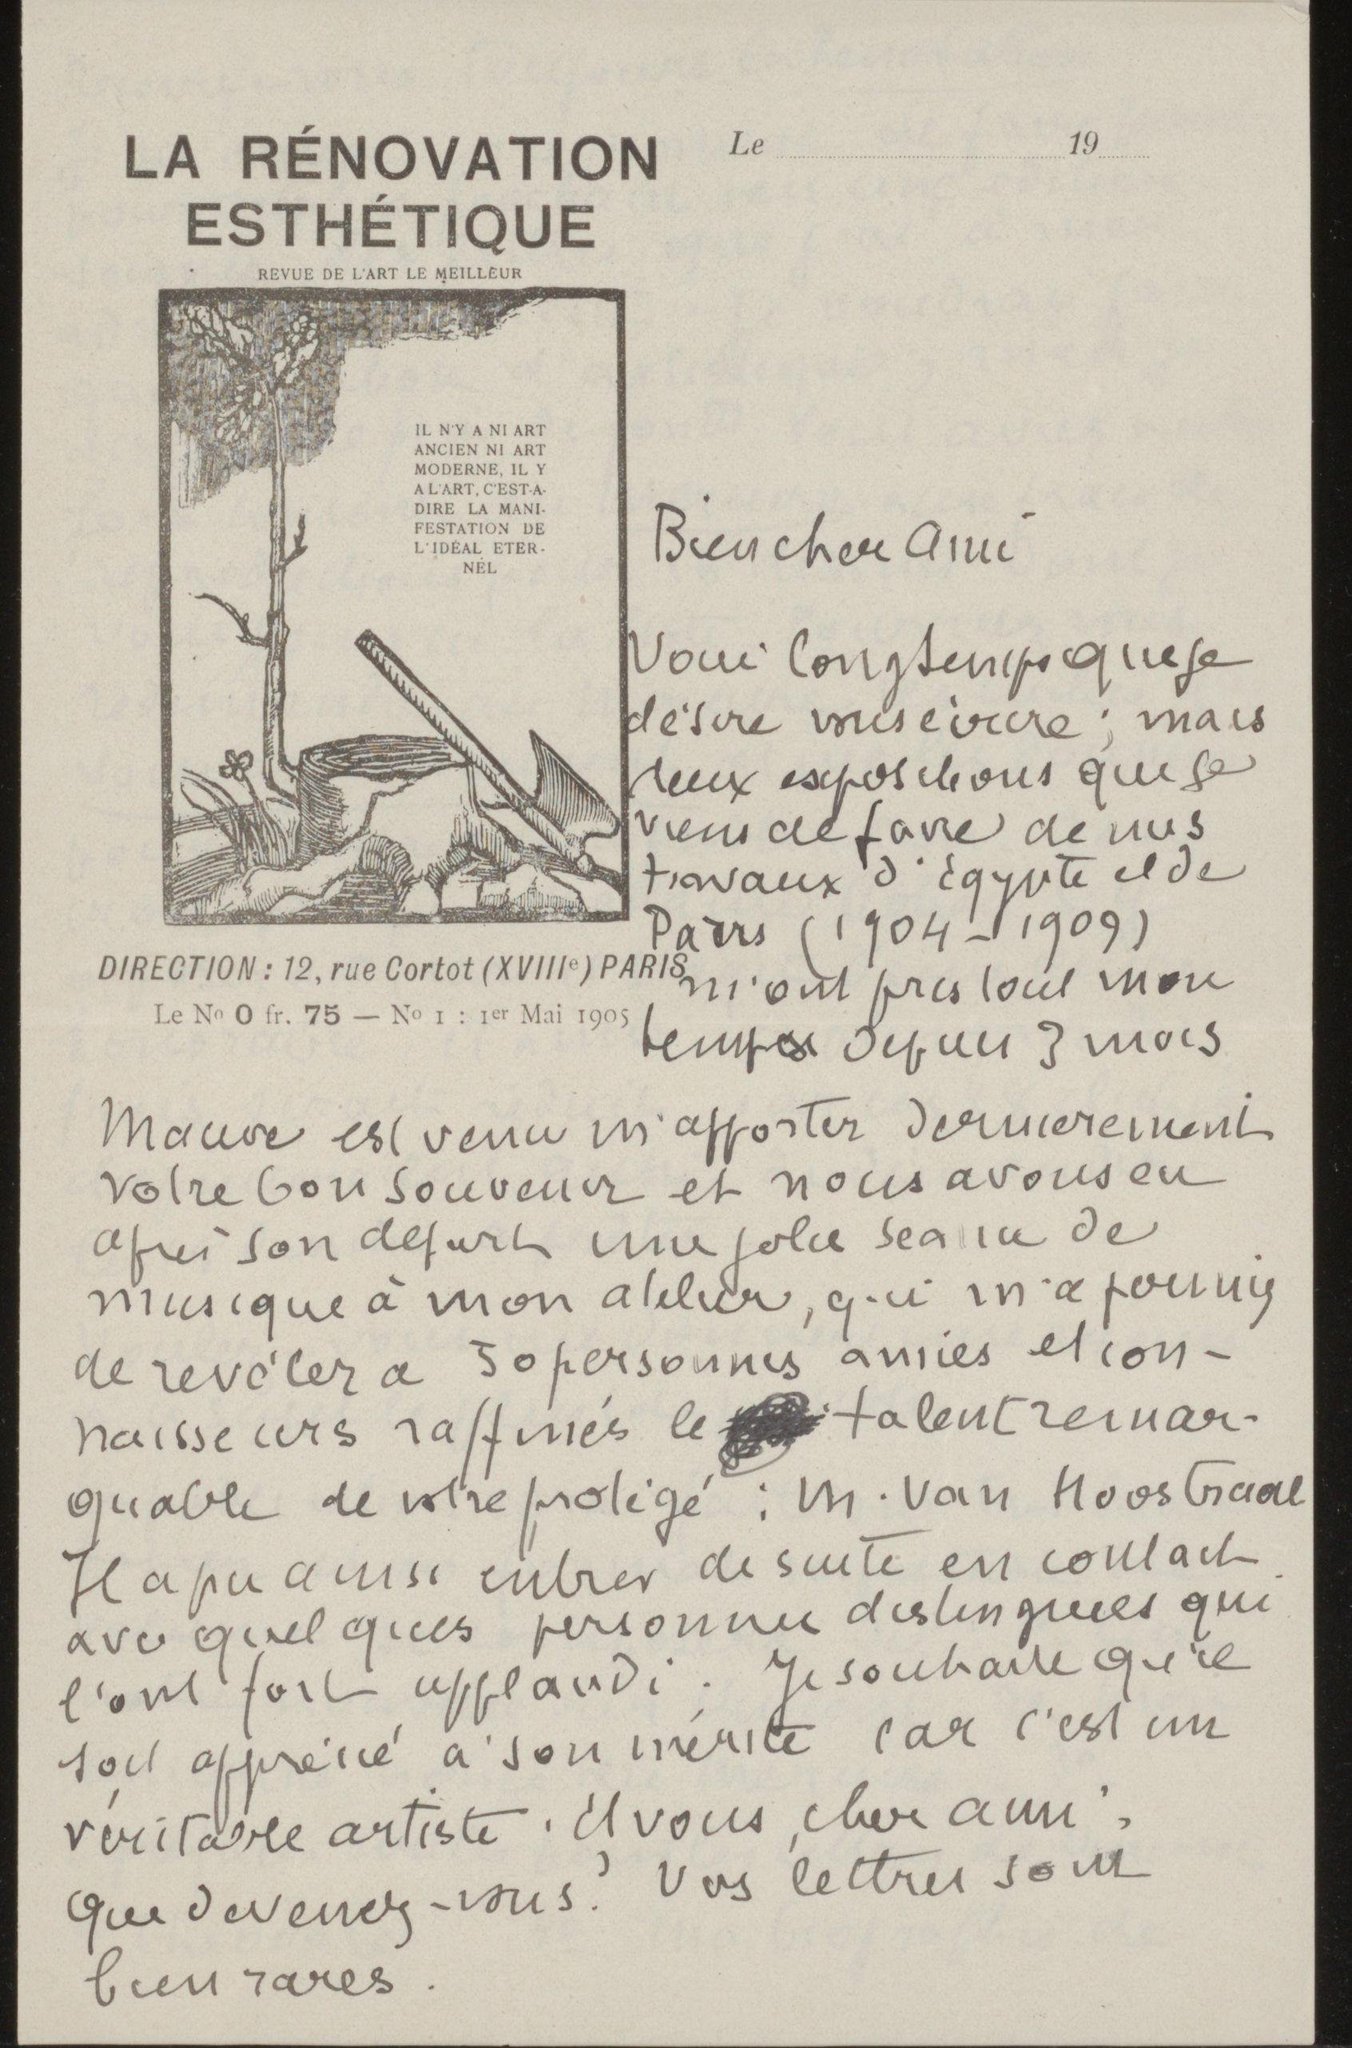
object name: letter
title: Brief aan Andries Bonger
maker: émile bernard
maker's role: print maker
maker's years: 1868-1941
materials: ink, paper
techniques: pen, printing, writing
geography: paris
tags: paris, odilon redon, painter, print maker, draughtsman, vincent van gogh, the hague, anton rudolf mauve, andries bonger, léon vanier, johanna bonger, drawing, music, workshop, studio of the artist (in general), exhibition ~ art, printed matter